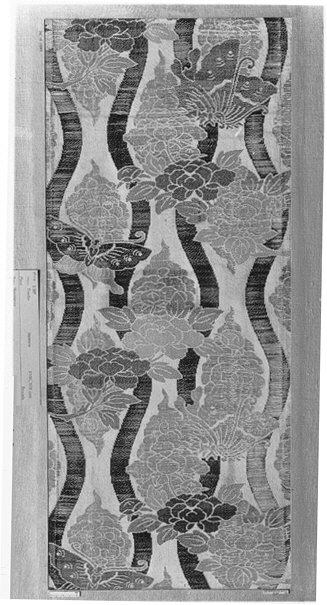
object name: piece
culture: japanese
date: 1701-1900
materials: silk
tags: butterflies